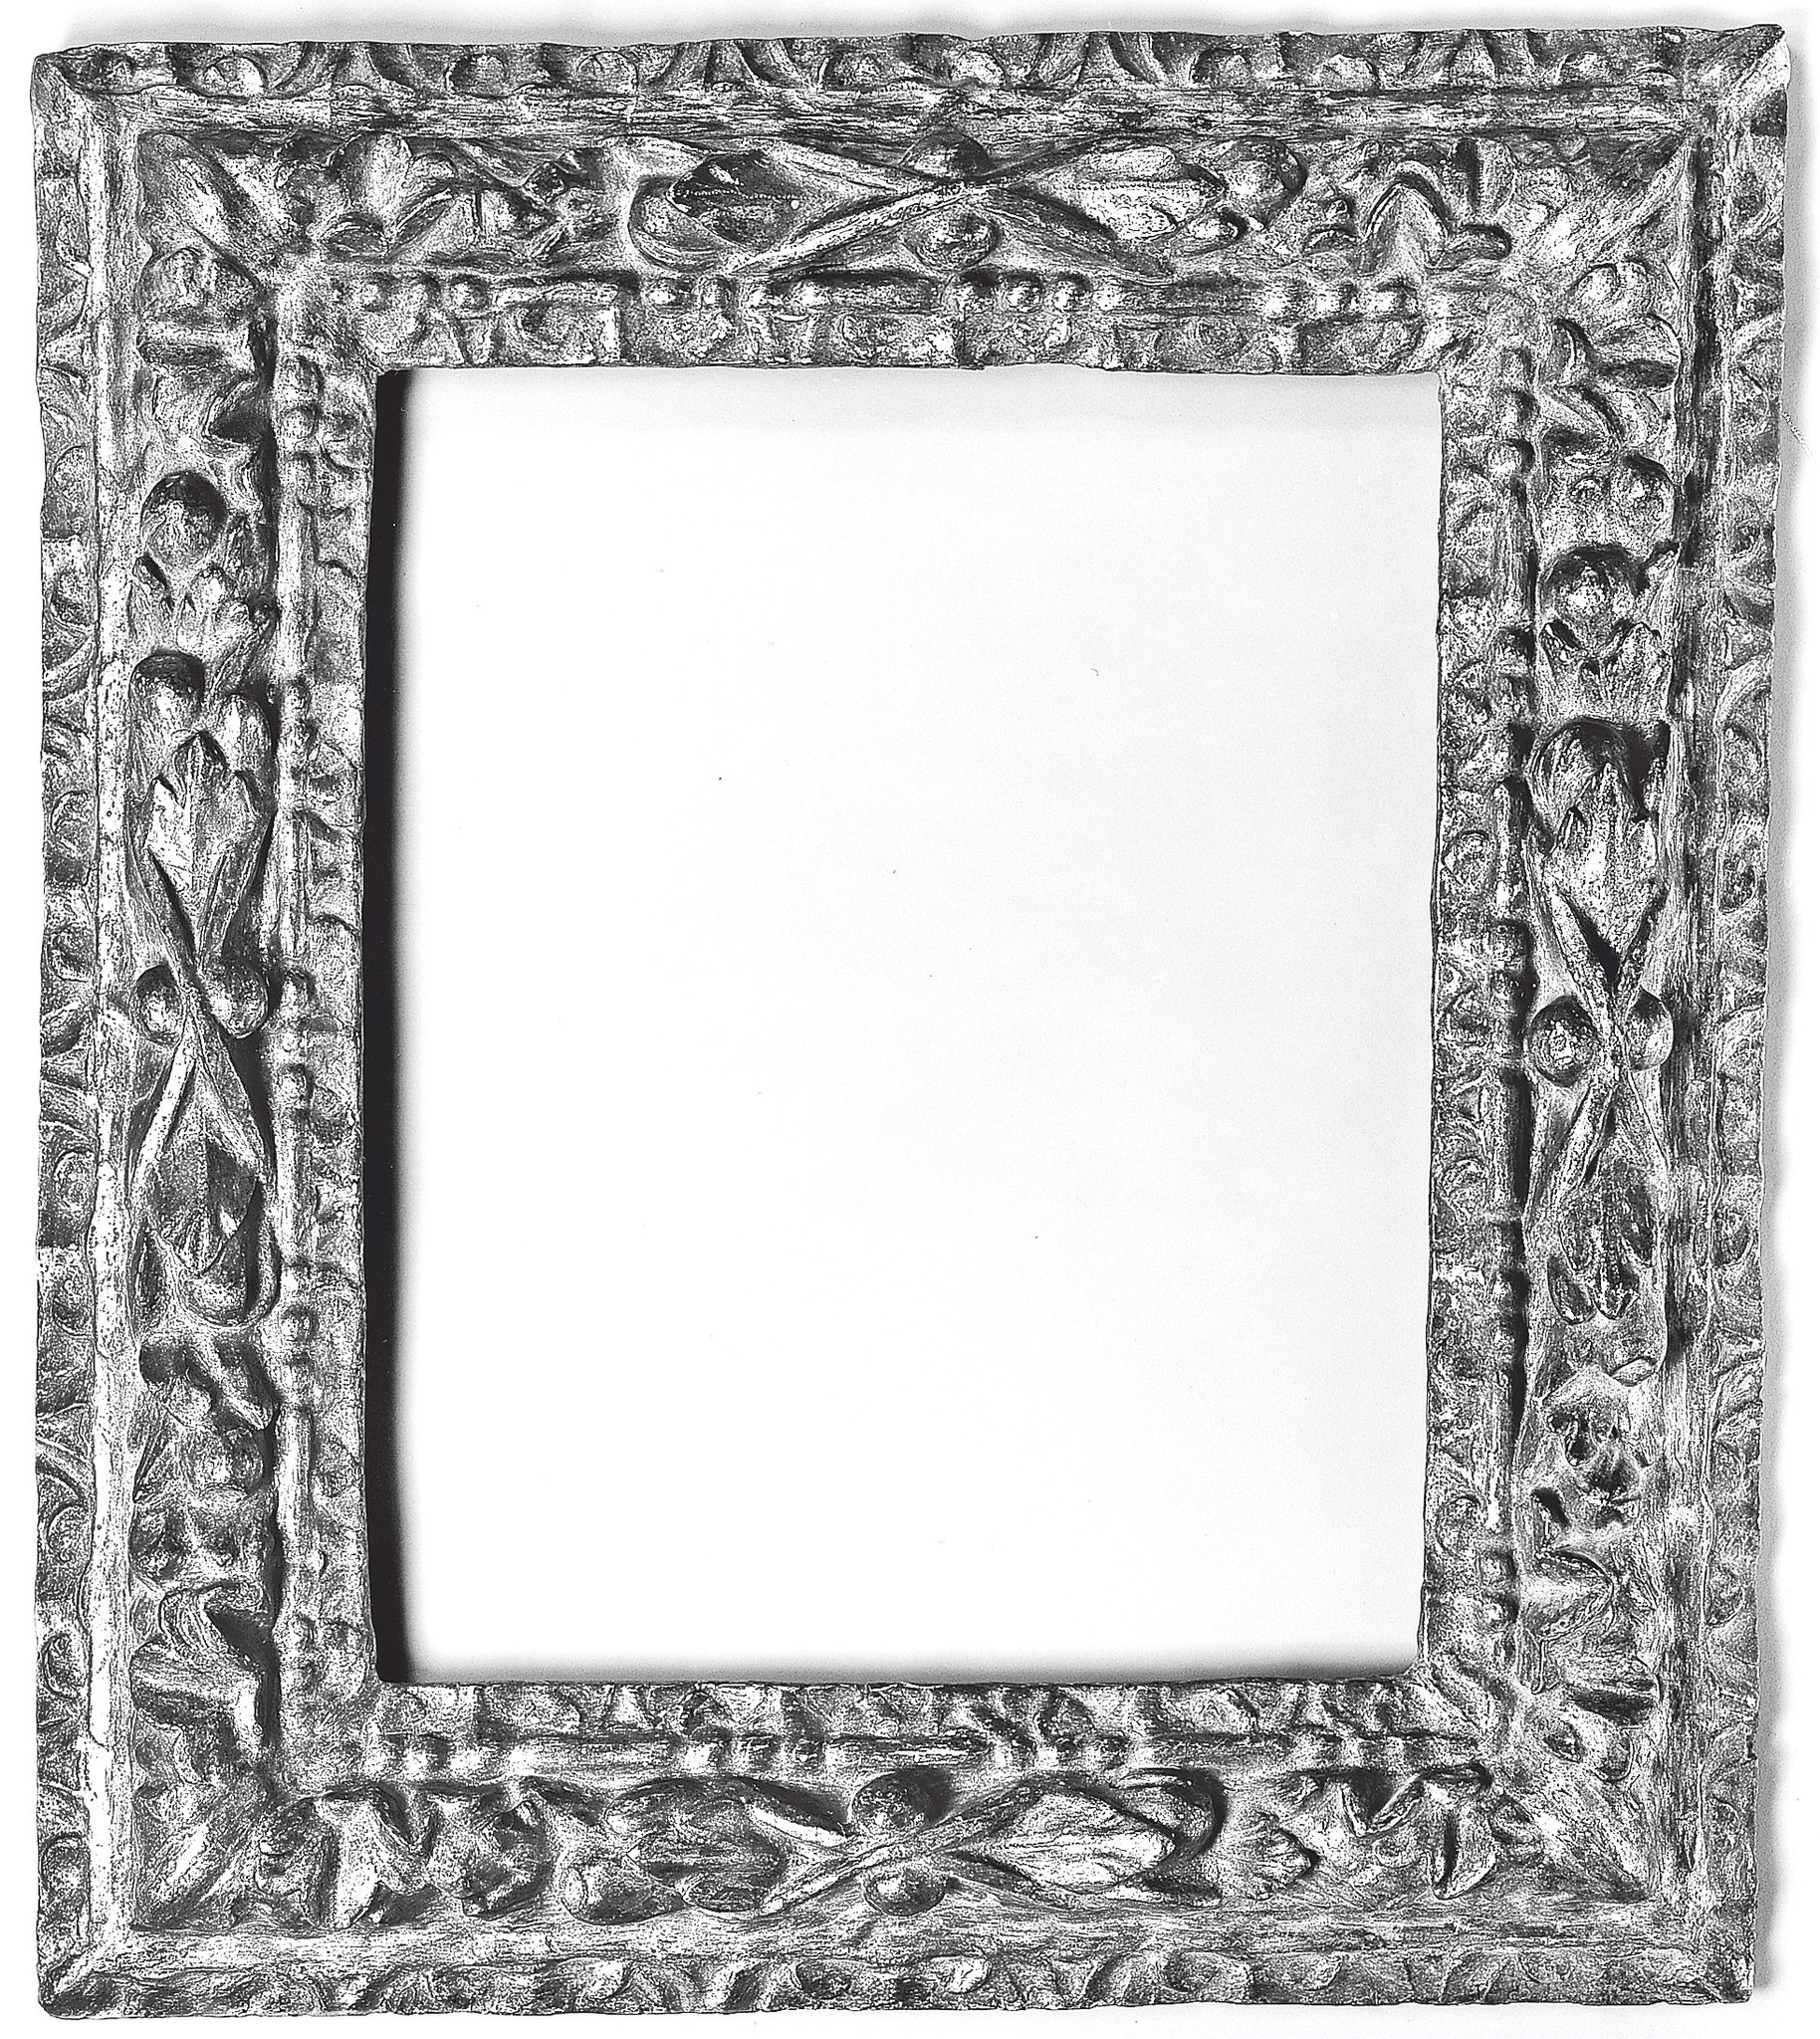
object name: frame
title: Astragal frame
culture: italian, veneto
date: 1567-1633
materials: gilt, wood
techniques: carving